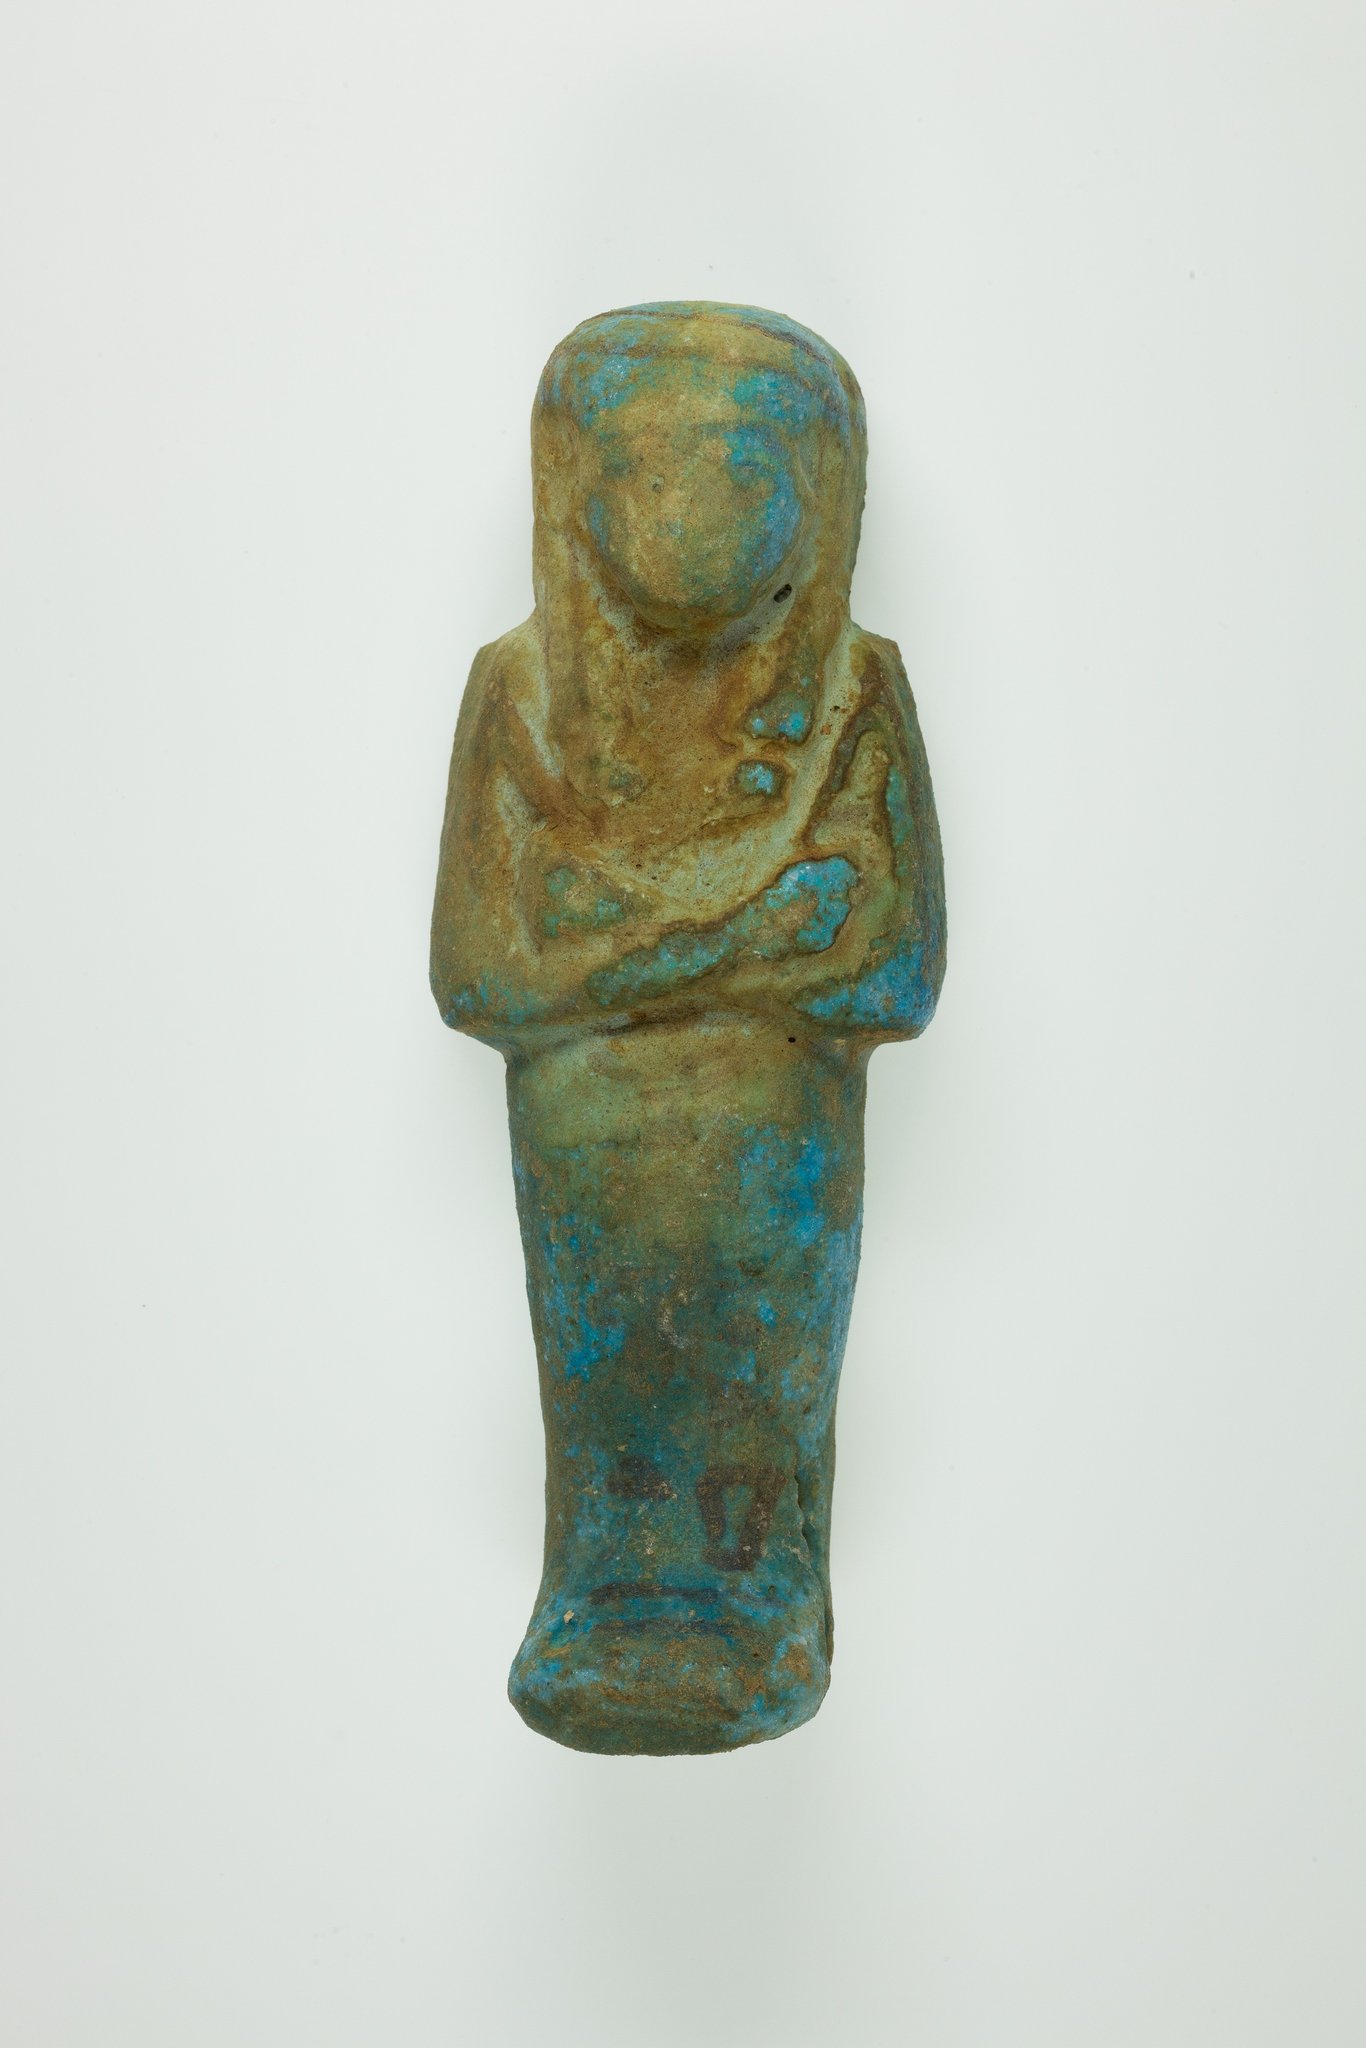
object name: worker shabti, henettawy c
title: Worker Shabti of Henettawy (C), Daughter of Isetemkheb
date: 990-970 BCE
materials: faience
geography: egypt